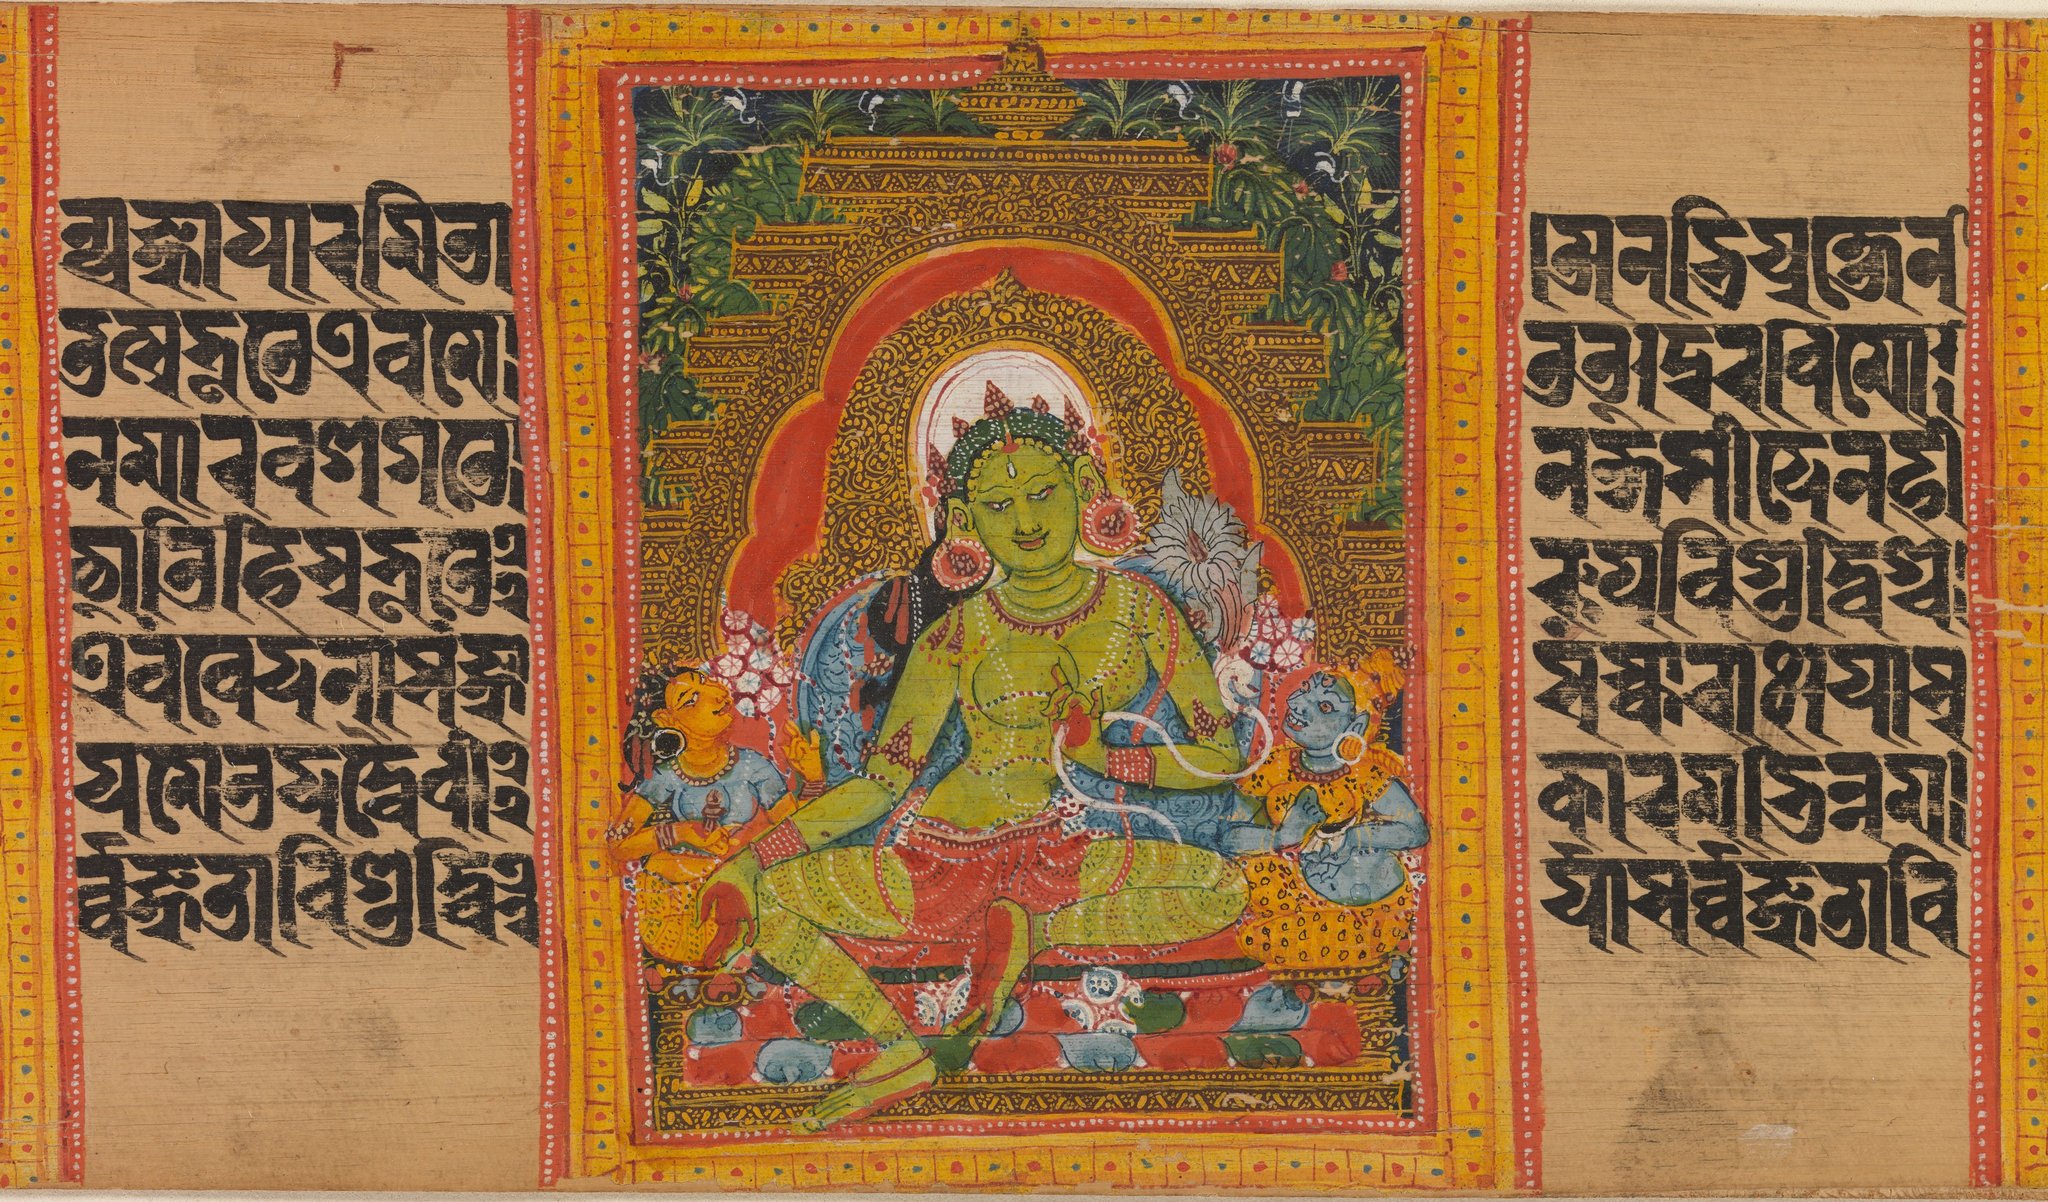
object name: folio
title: Green Tara, Folio from a dispersed Ashtasahasrika Prajnaparamita (Perfection of Wisdom) Manuscript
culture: indian, bengal or bangladesh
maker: mahavihara master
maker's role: artist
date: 1101-1133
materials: leaf, watercolor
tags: buddhism